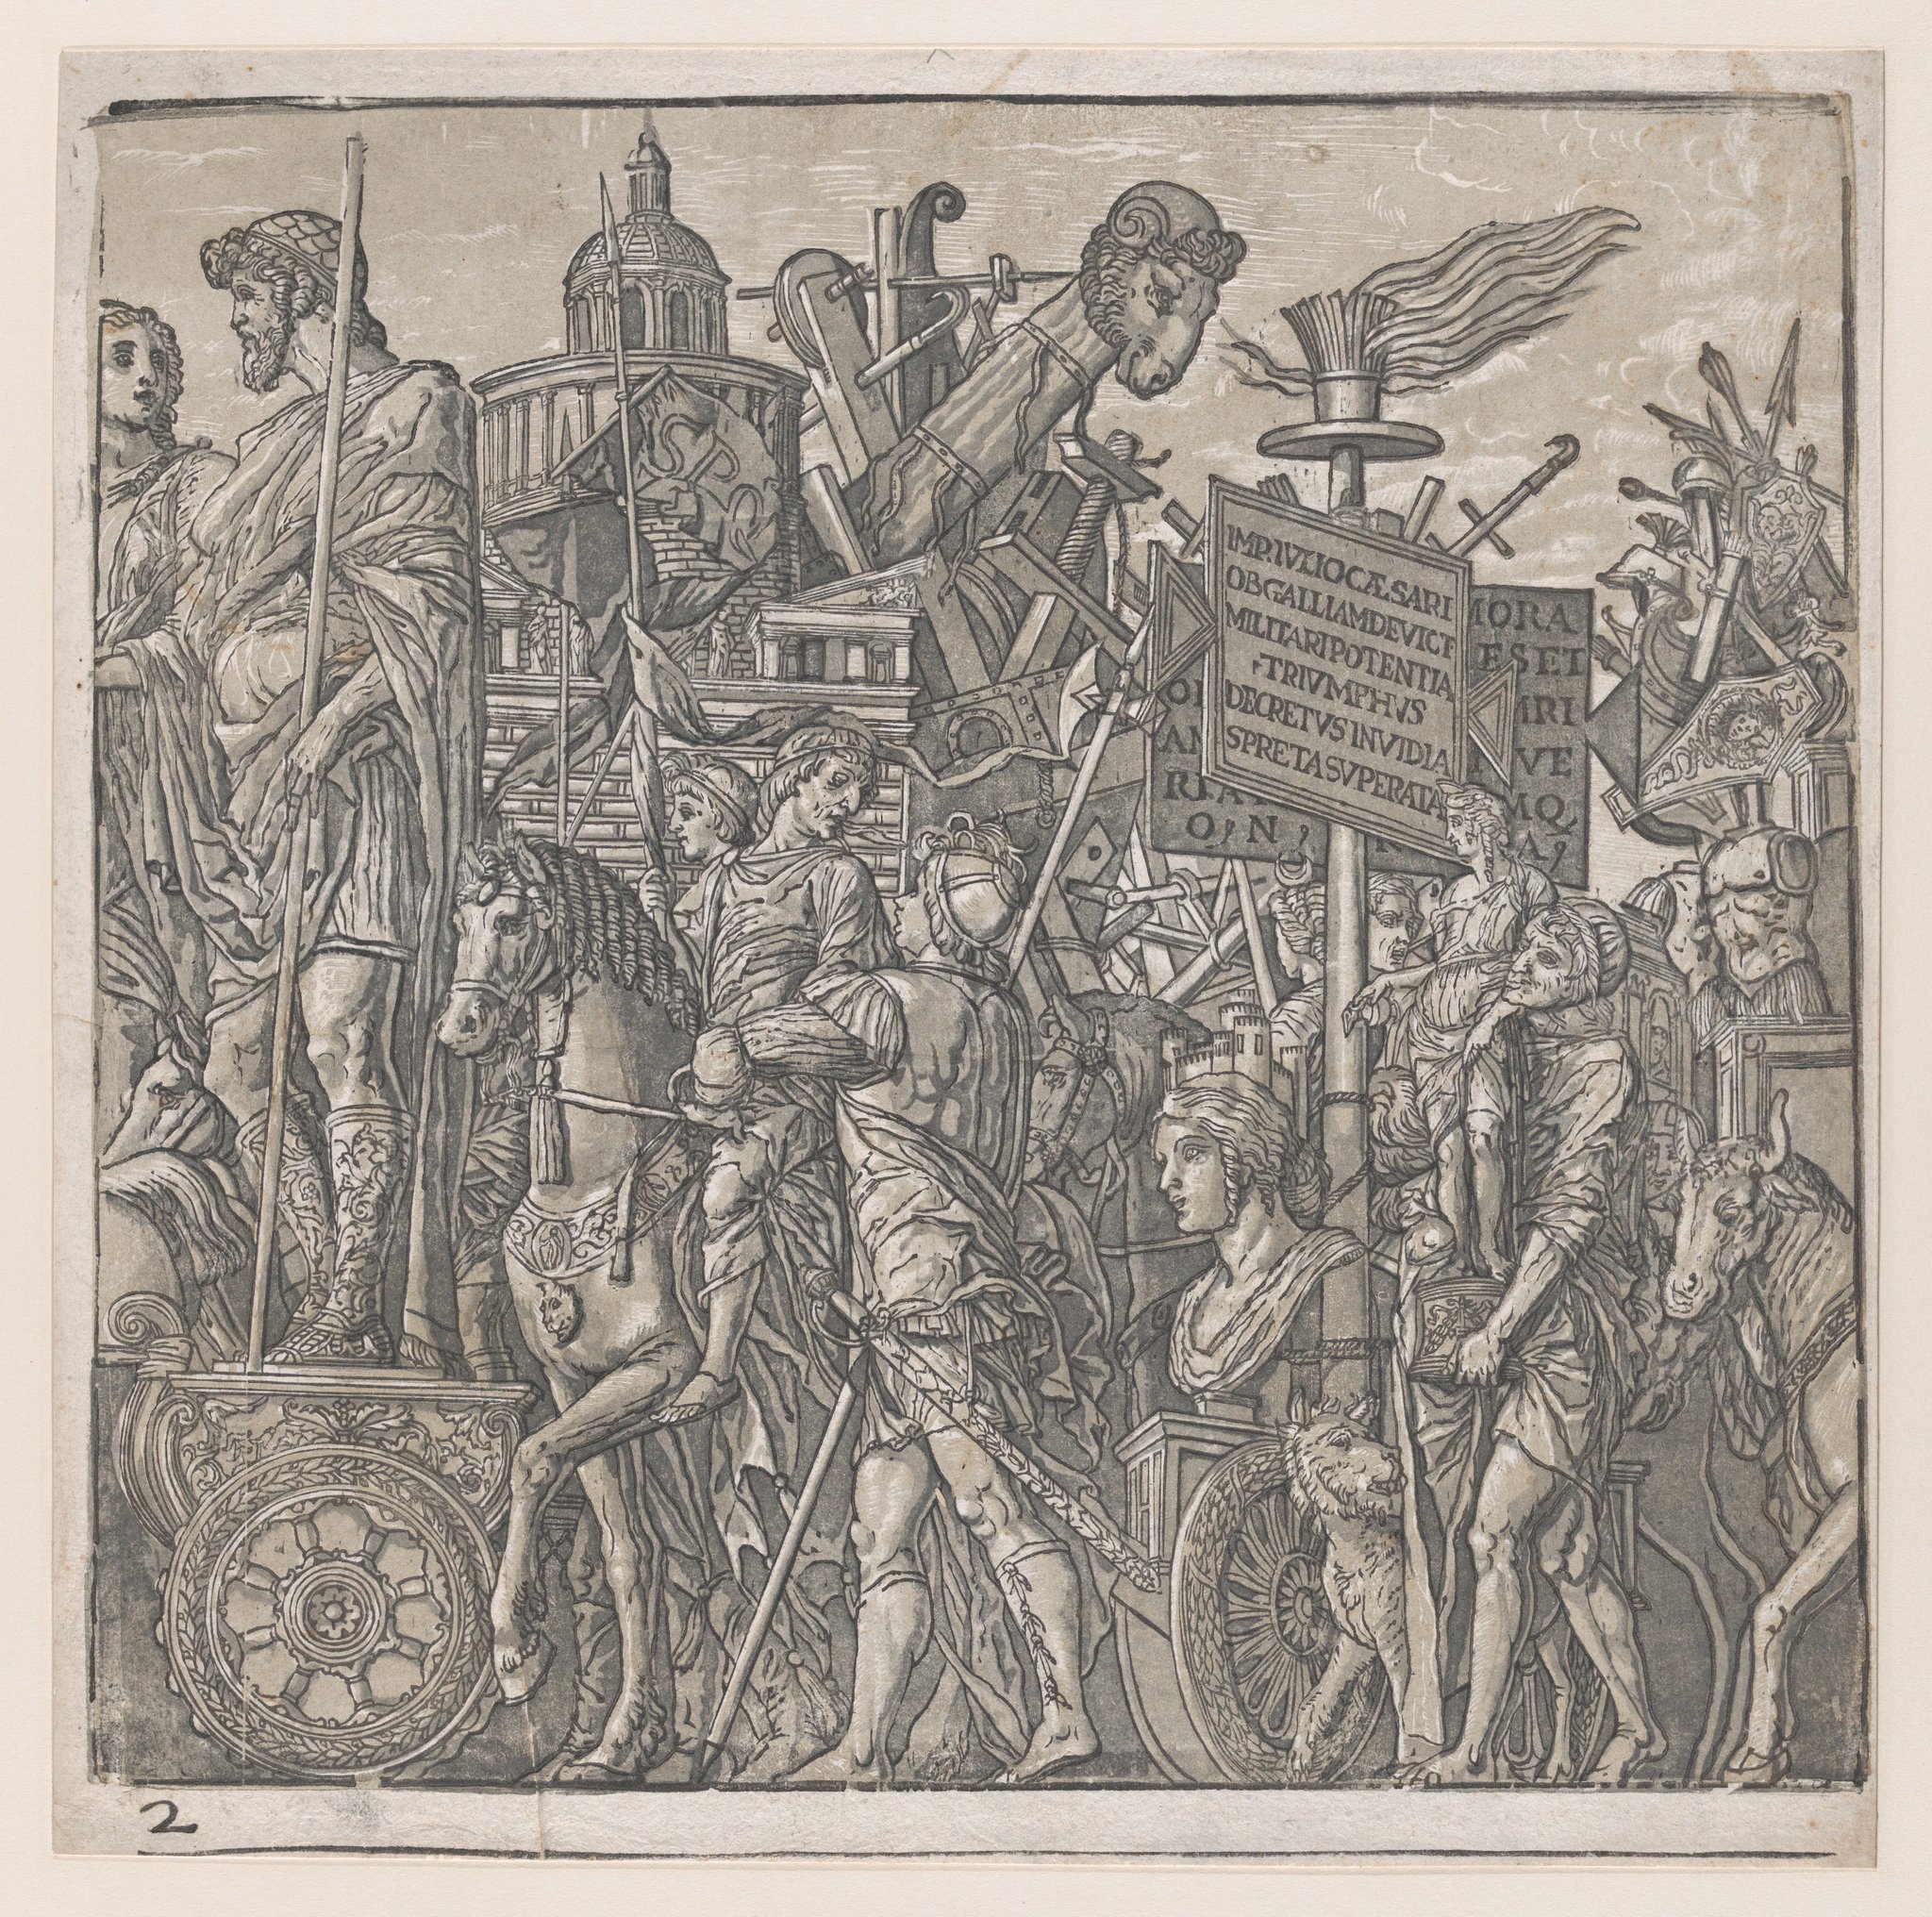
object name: print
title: Sheet 2: A Triumphal Chariot, from "The Triumph of Julius Caesar"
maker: andrea andreani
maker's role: artist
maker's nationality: italian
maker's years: 1558-1629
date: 1599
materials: ink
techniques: woodcut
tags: julius caesar,men,horses,chariots